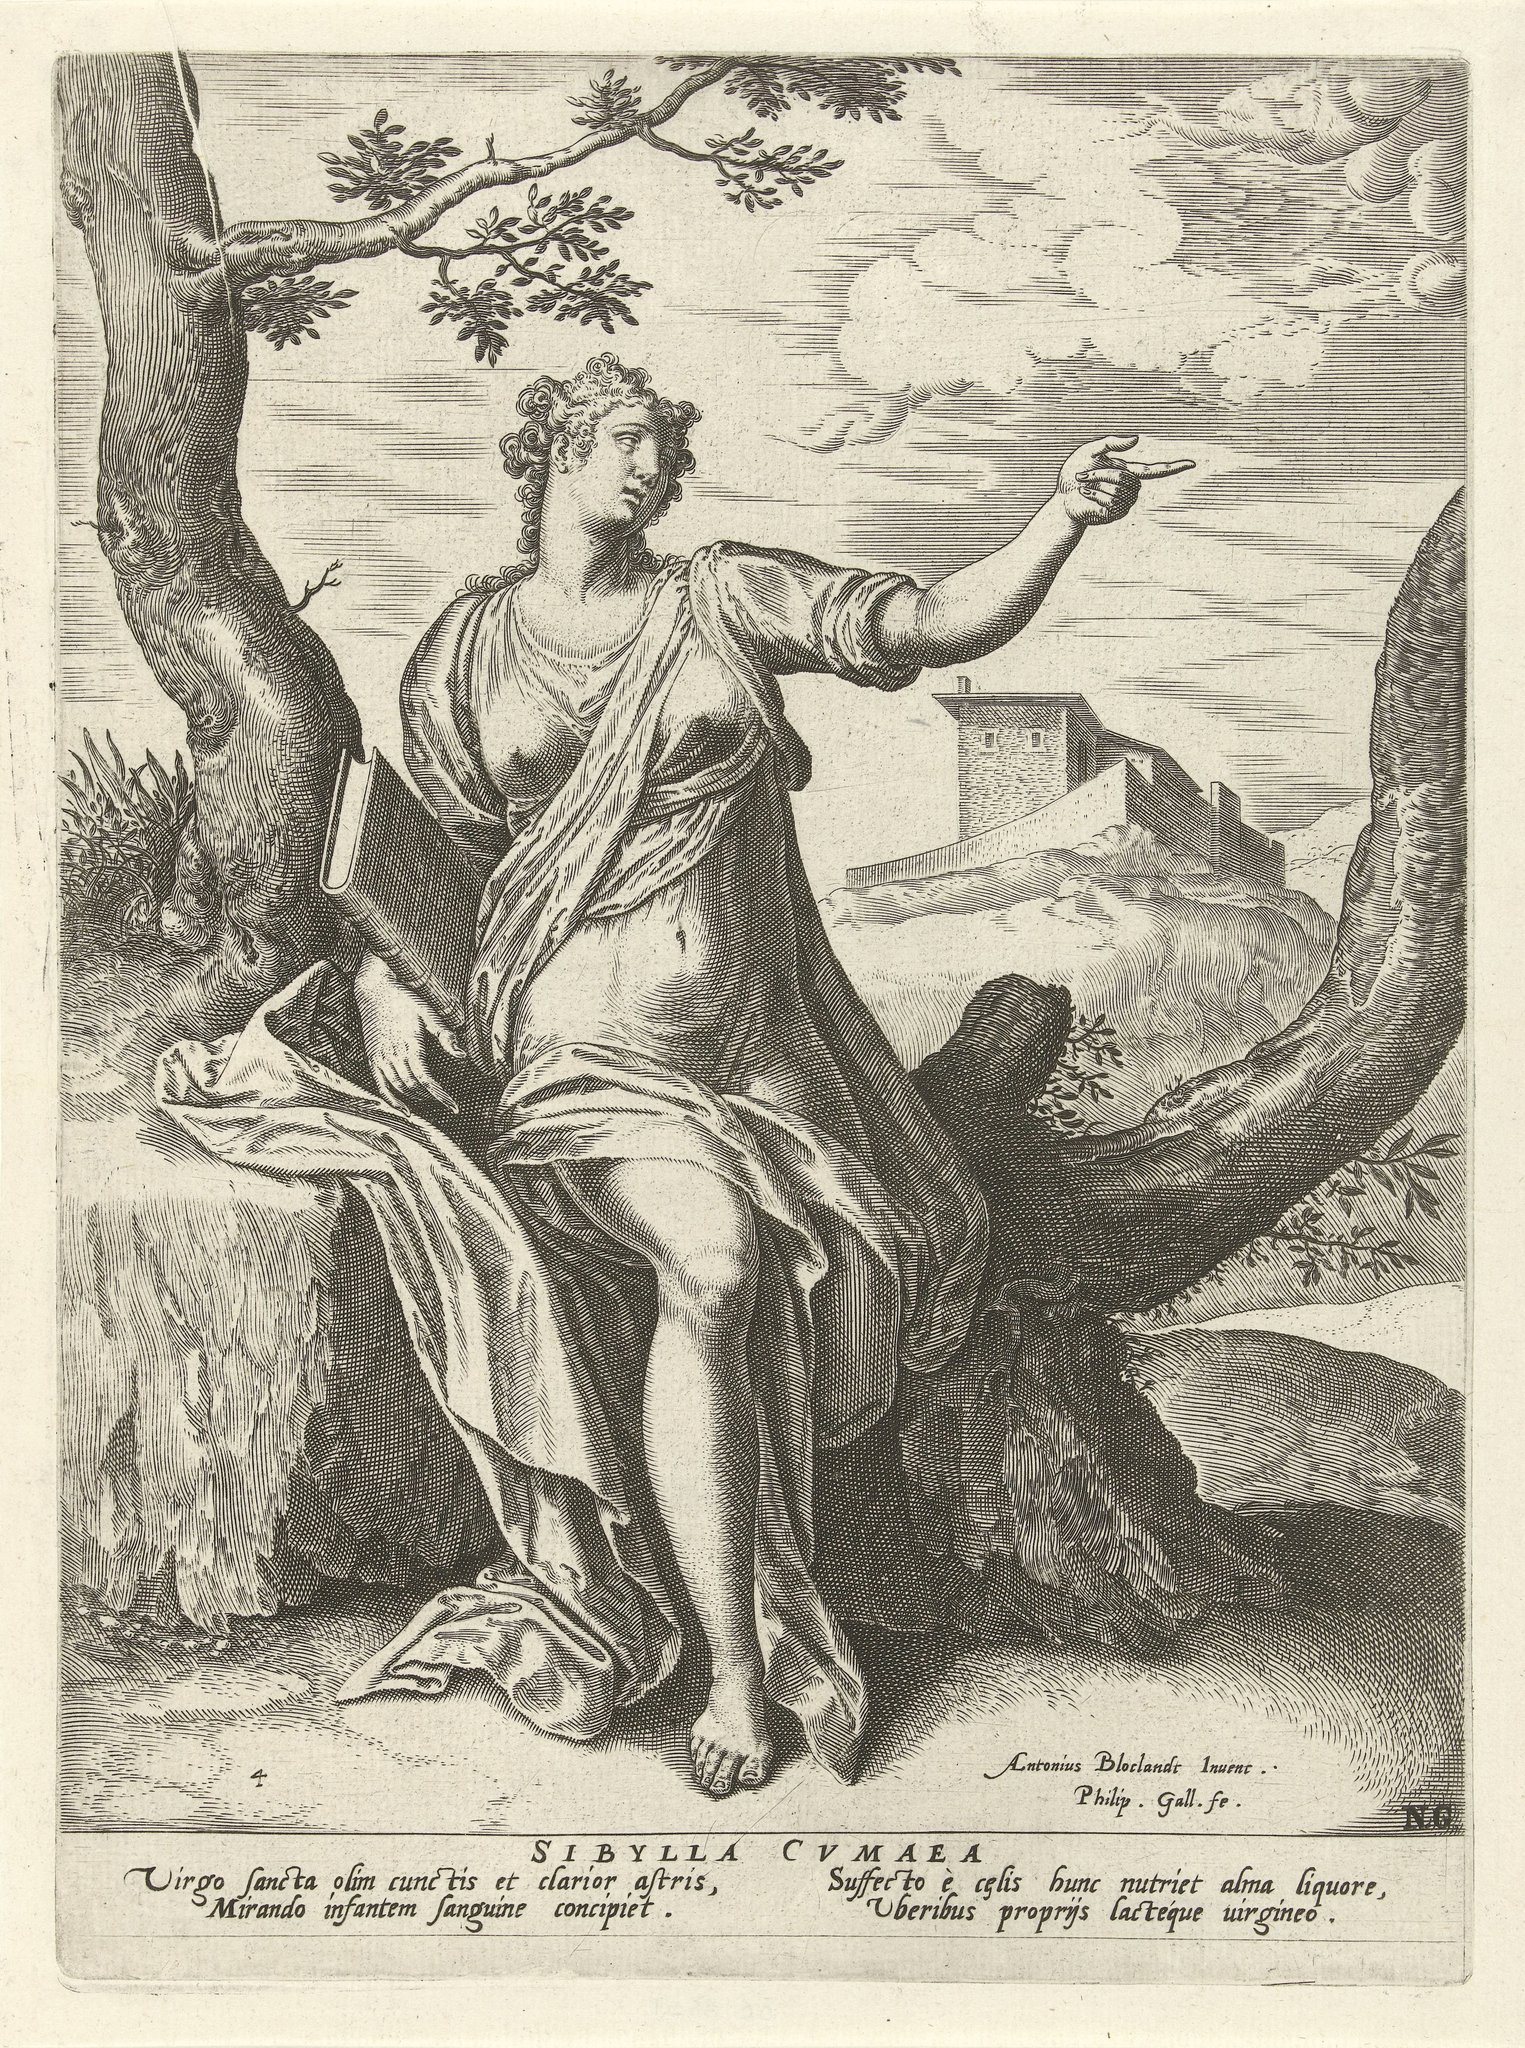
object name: print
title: Sibillen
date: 1575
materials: paper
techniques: engraving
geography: antwerp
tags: cumaean sibyl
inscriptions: collector's mark: Lugt 2228, collector's mark: Lugt 1967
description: De Sibille van Cumae zit op een boomstronk. Ze heeft een boek vast. De prent heeft een Latijns onderschrift en maakt deel uit van een tiendelige serie over de Sibillen.